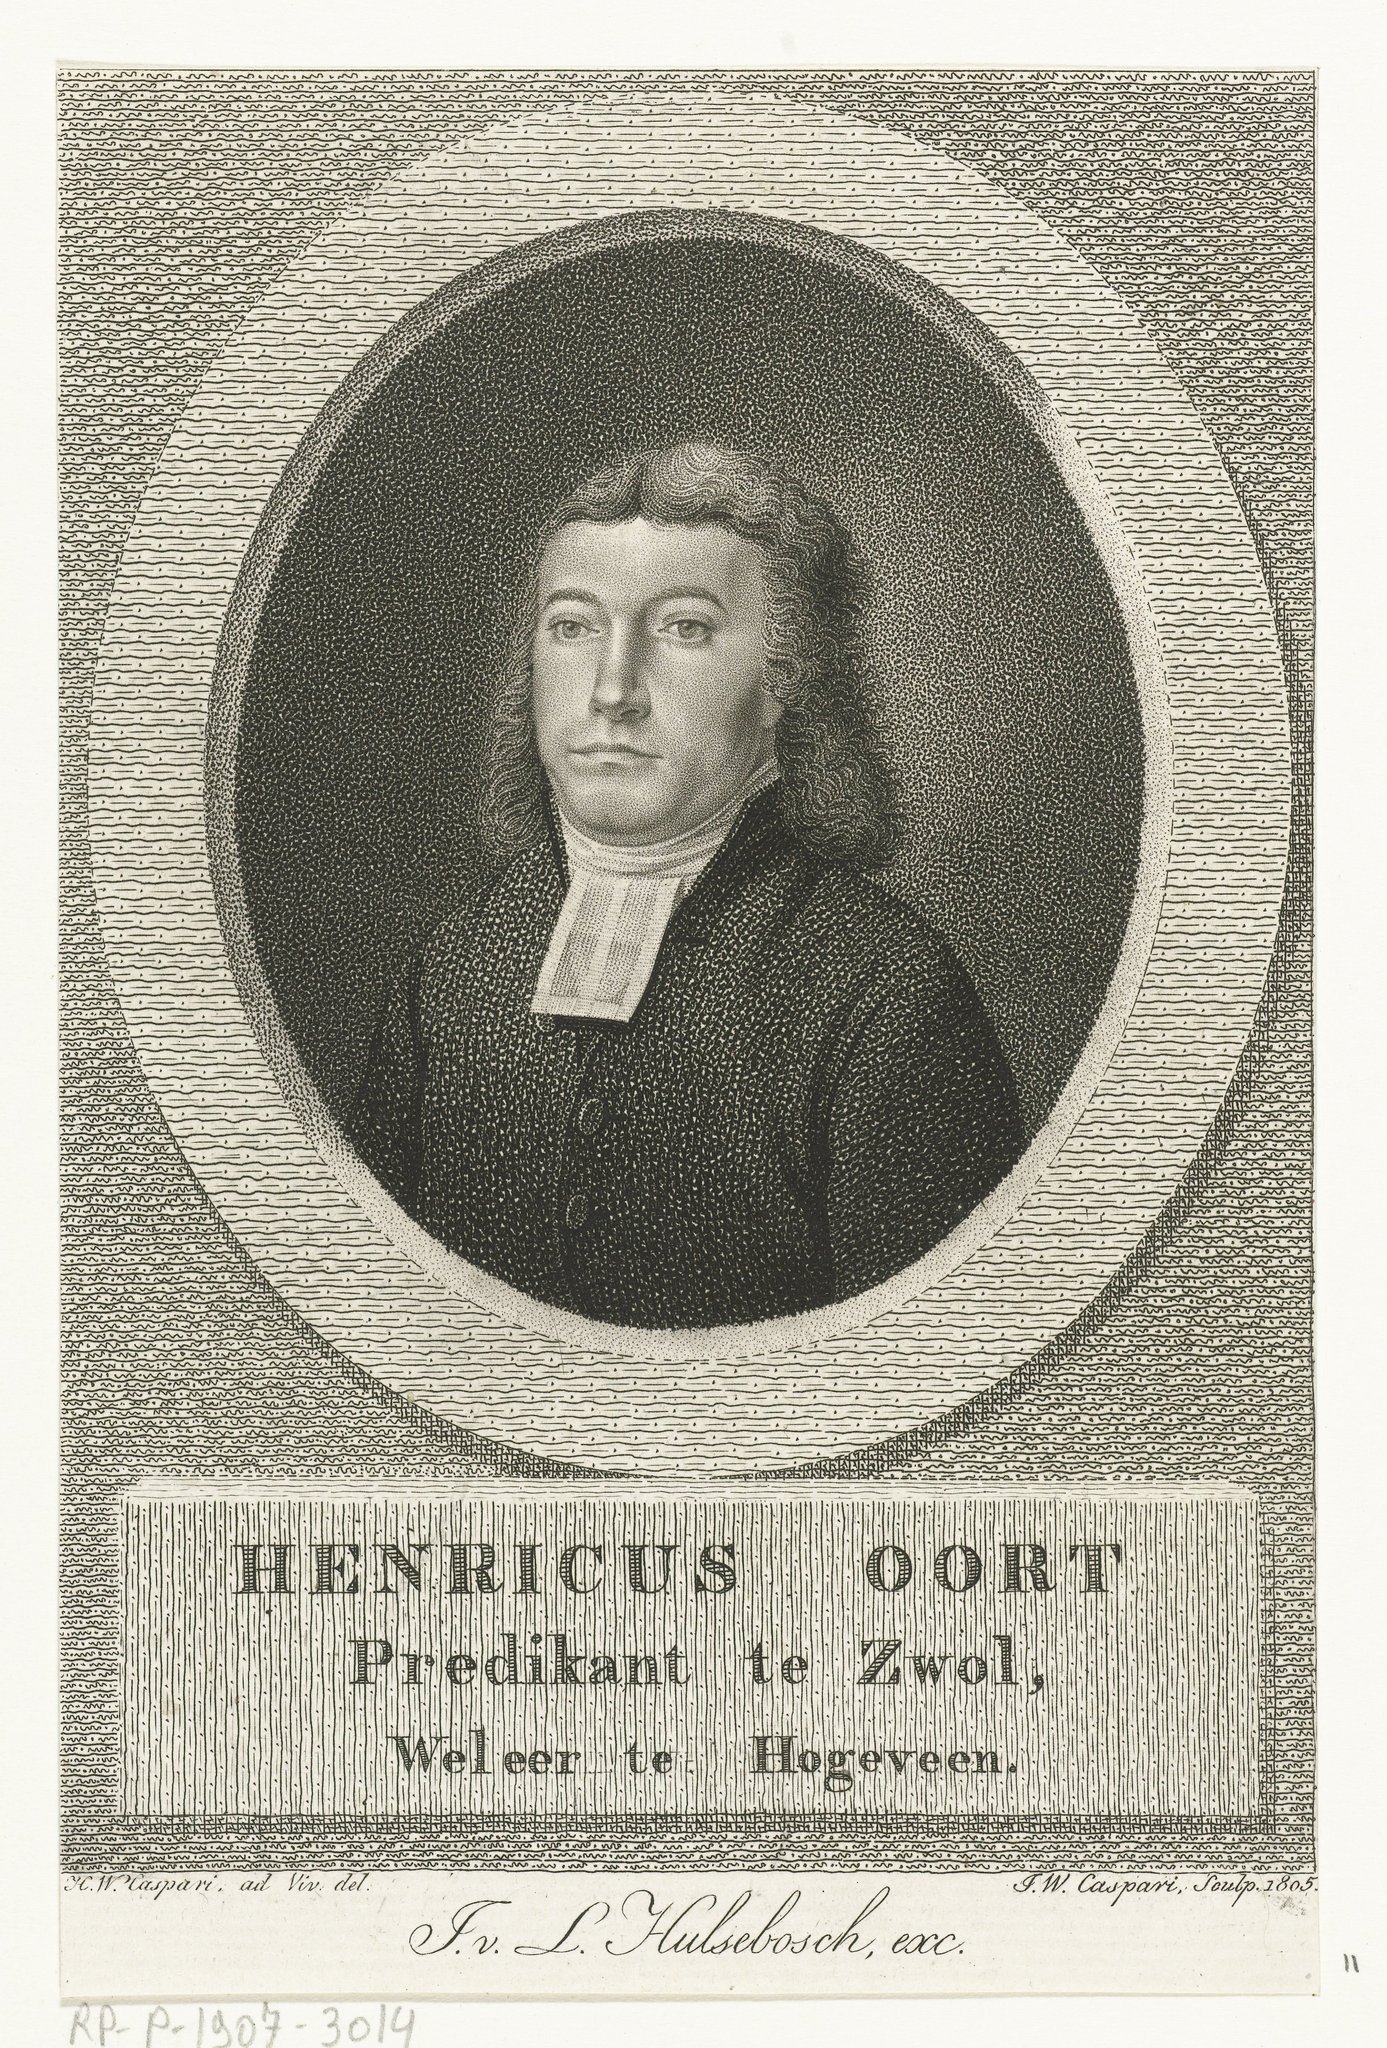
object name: print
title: Portret van Henricus Oort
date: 1805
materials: paper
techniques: etching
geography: amsterdam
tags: rotterdam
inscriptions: collector's mark: Lugt 2166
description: Portret in ovale lijst van Henricus Oort, predikant te Zwolle en Hoogeveen. Buste naar links. Oort heeft een zwarte toga aan met een witte bef. De prent heeft een Nederlands onderschrift met naam geportretteerde.